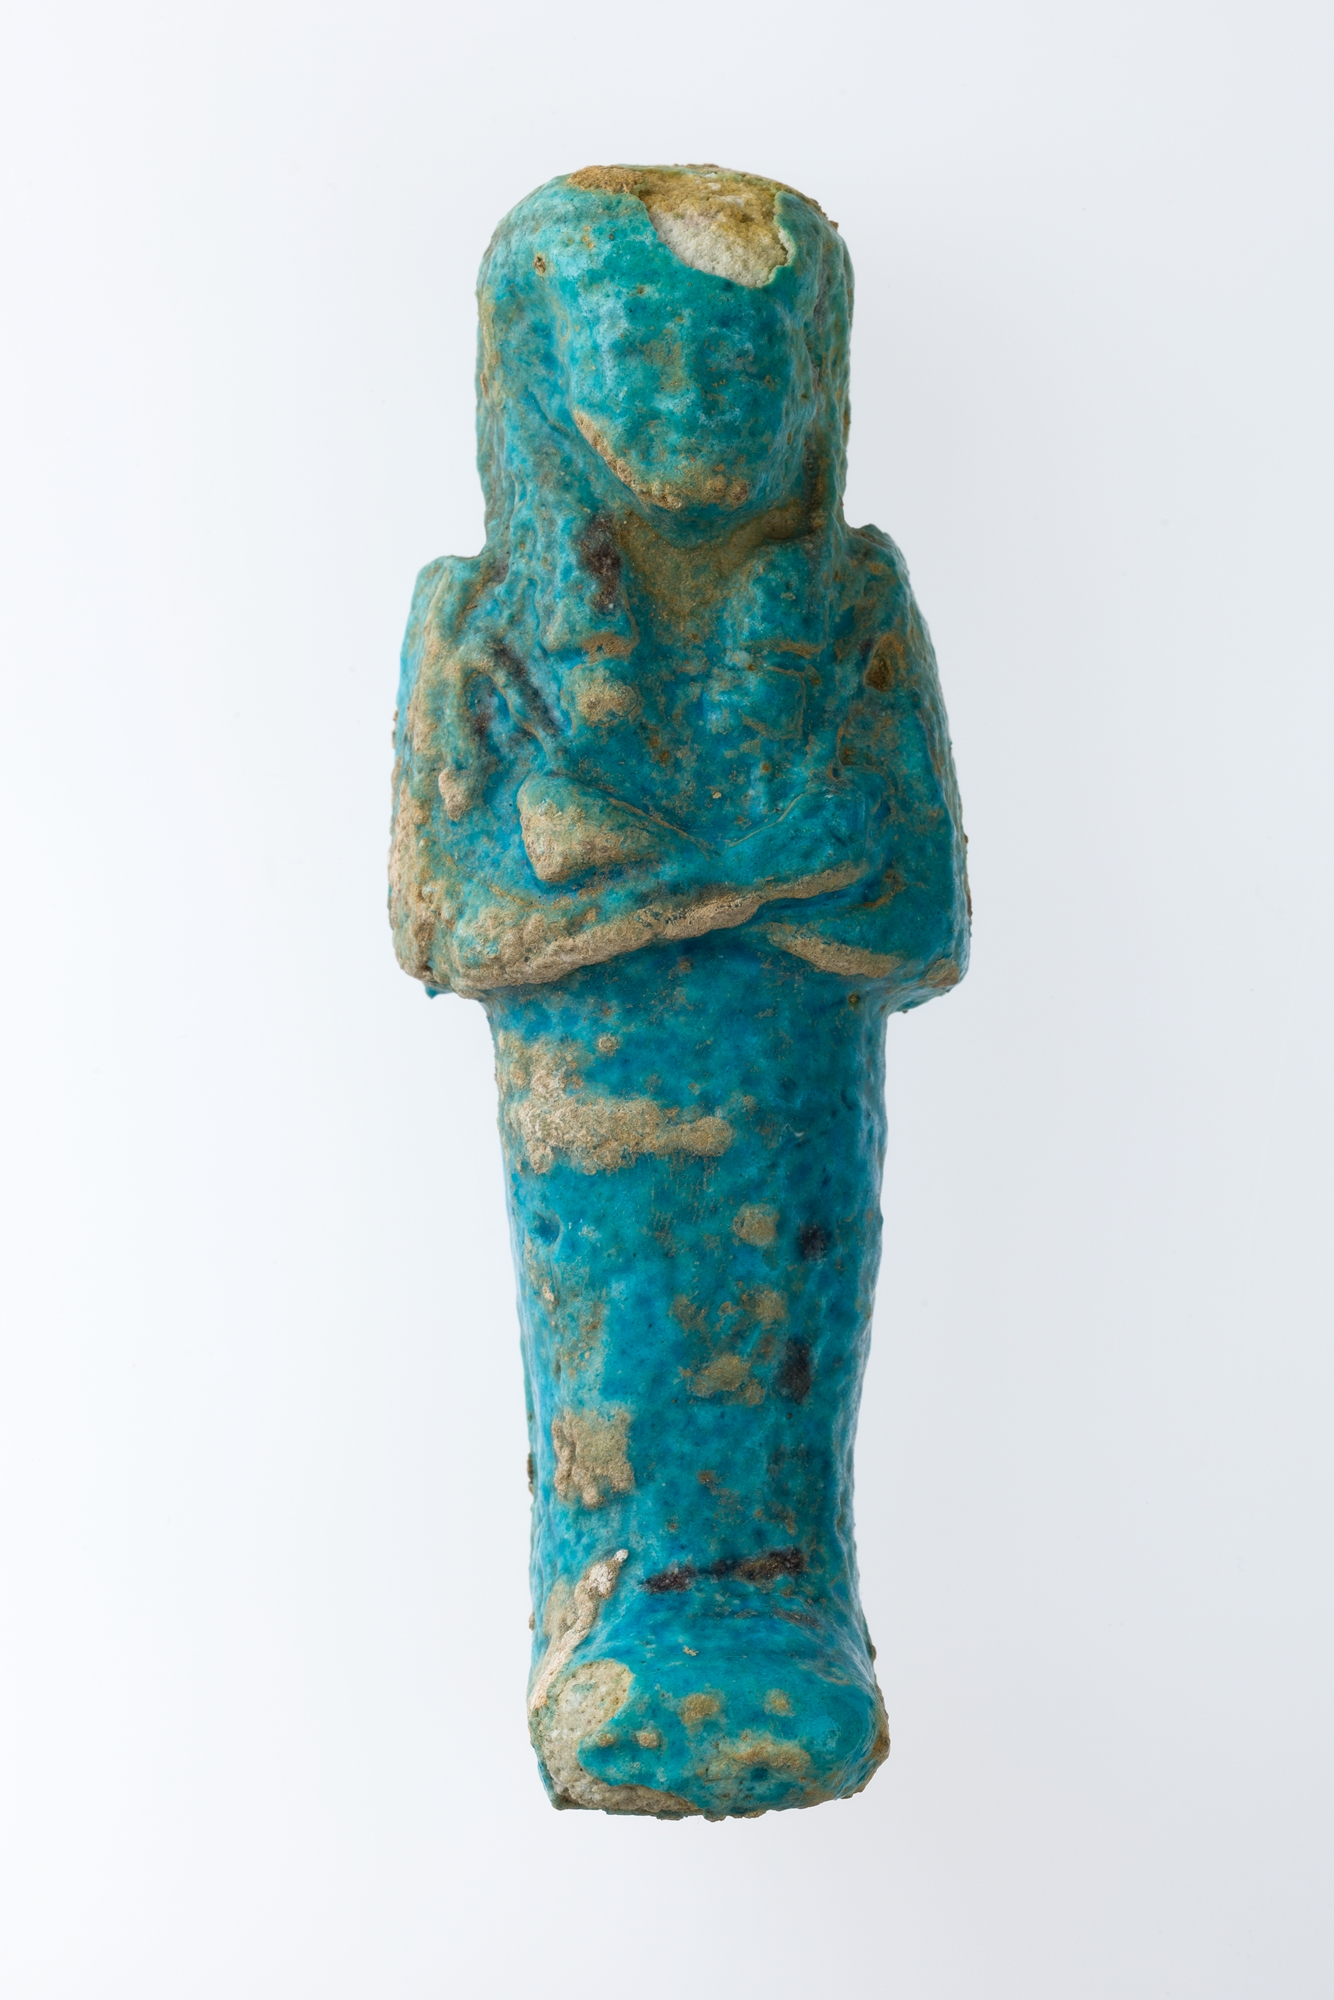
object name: shabti, henettawy c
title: Worker Shabti of Henettawy (C), Daughter of Isetemkheb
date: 990-970 BCE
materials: faience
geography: egypt